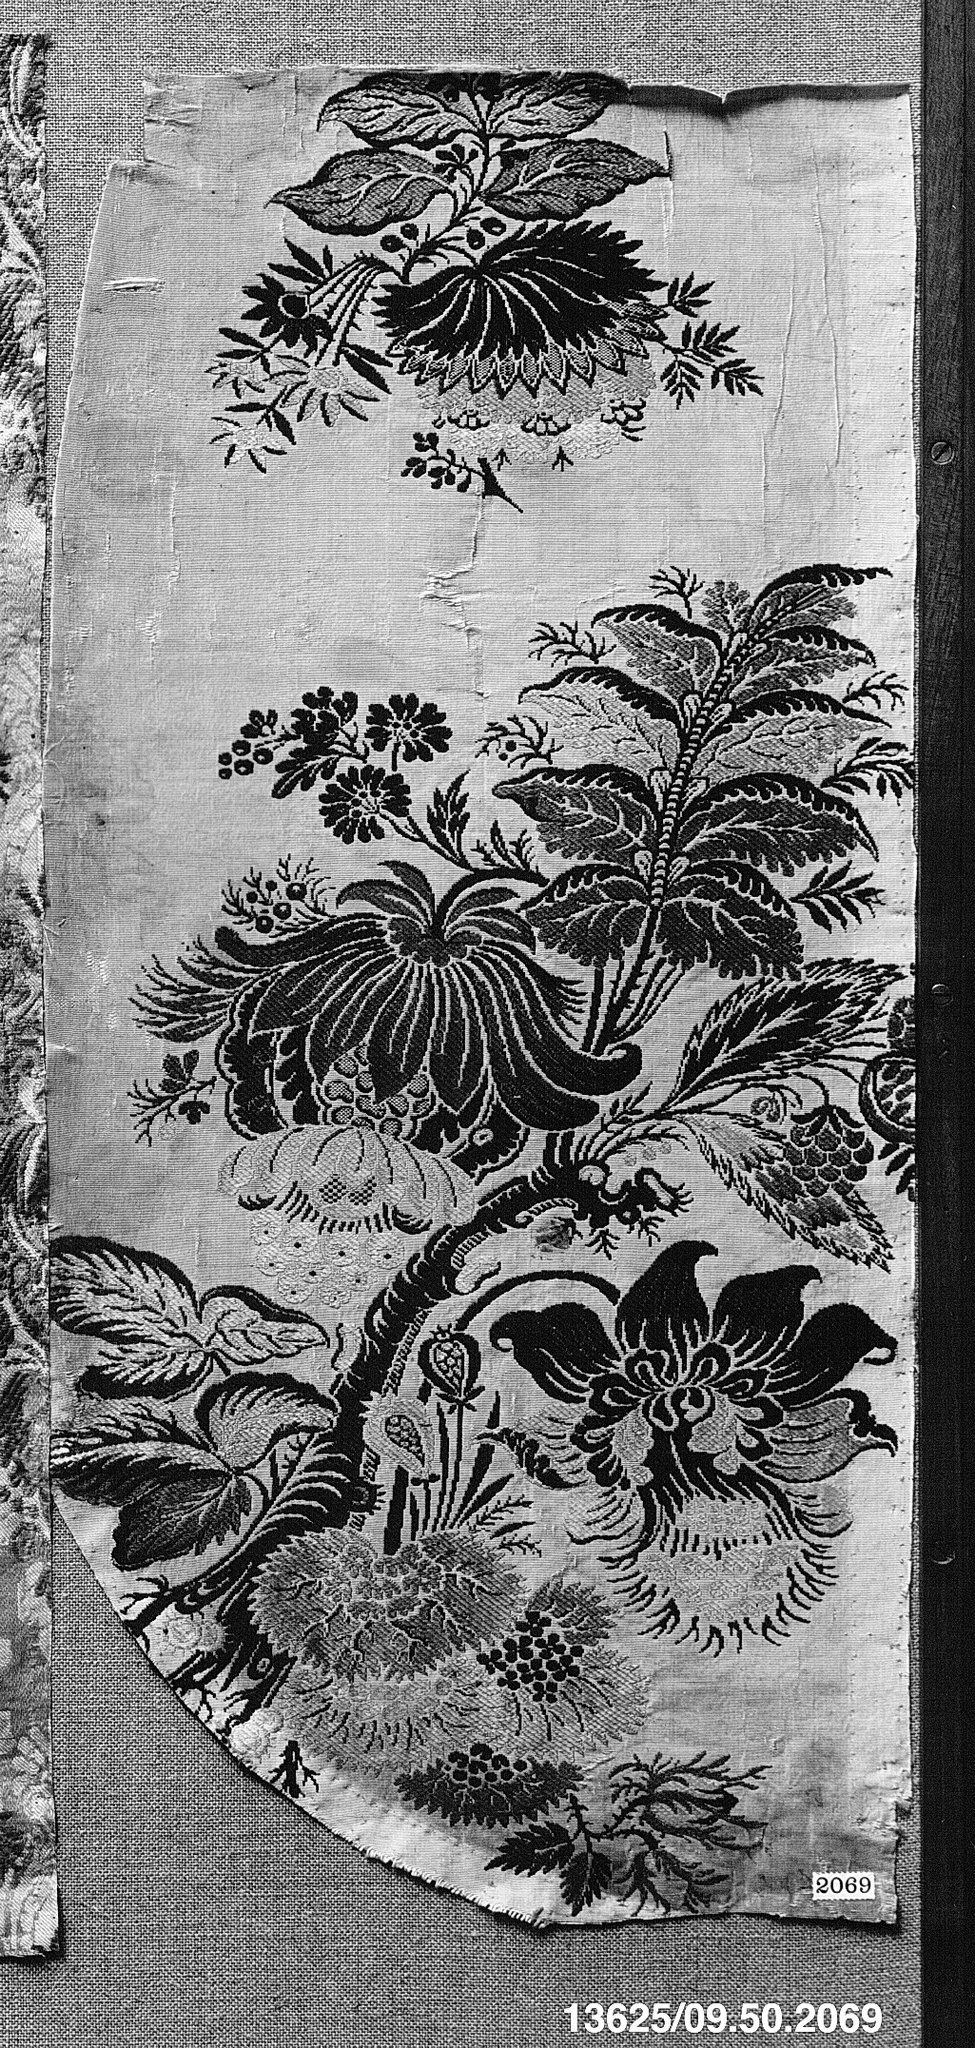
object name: piece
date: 1740-1750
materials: silk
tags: flowers,leaves